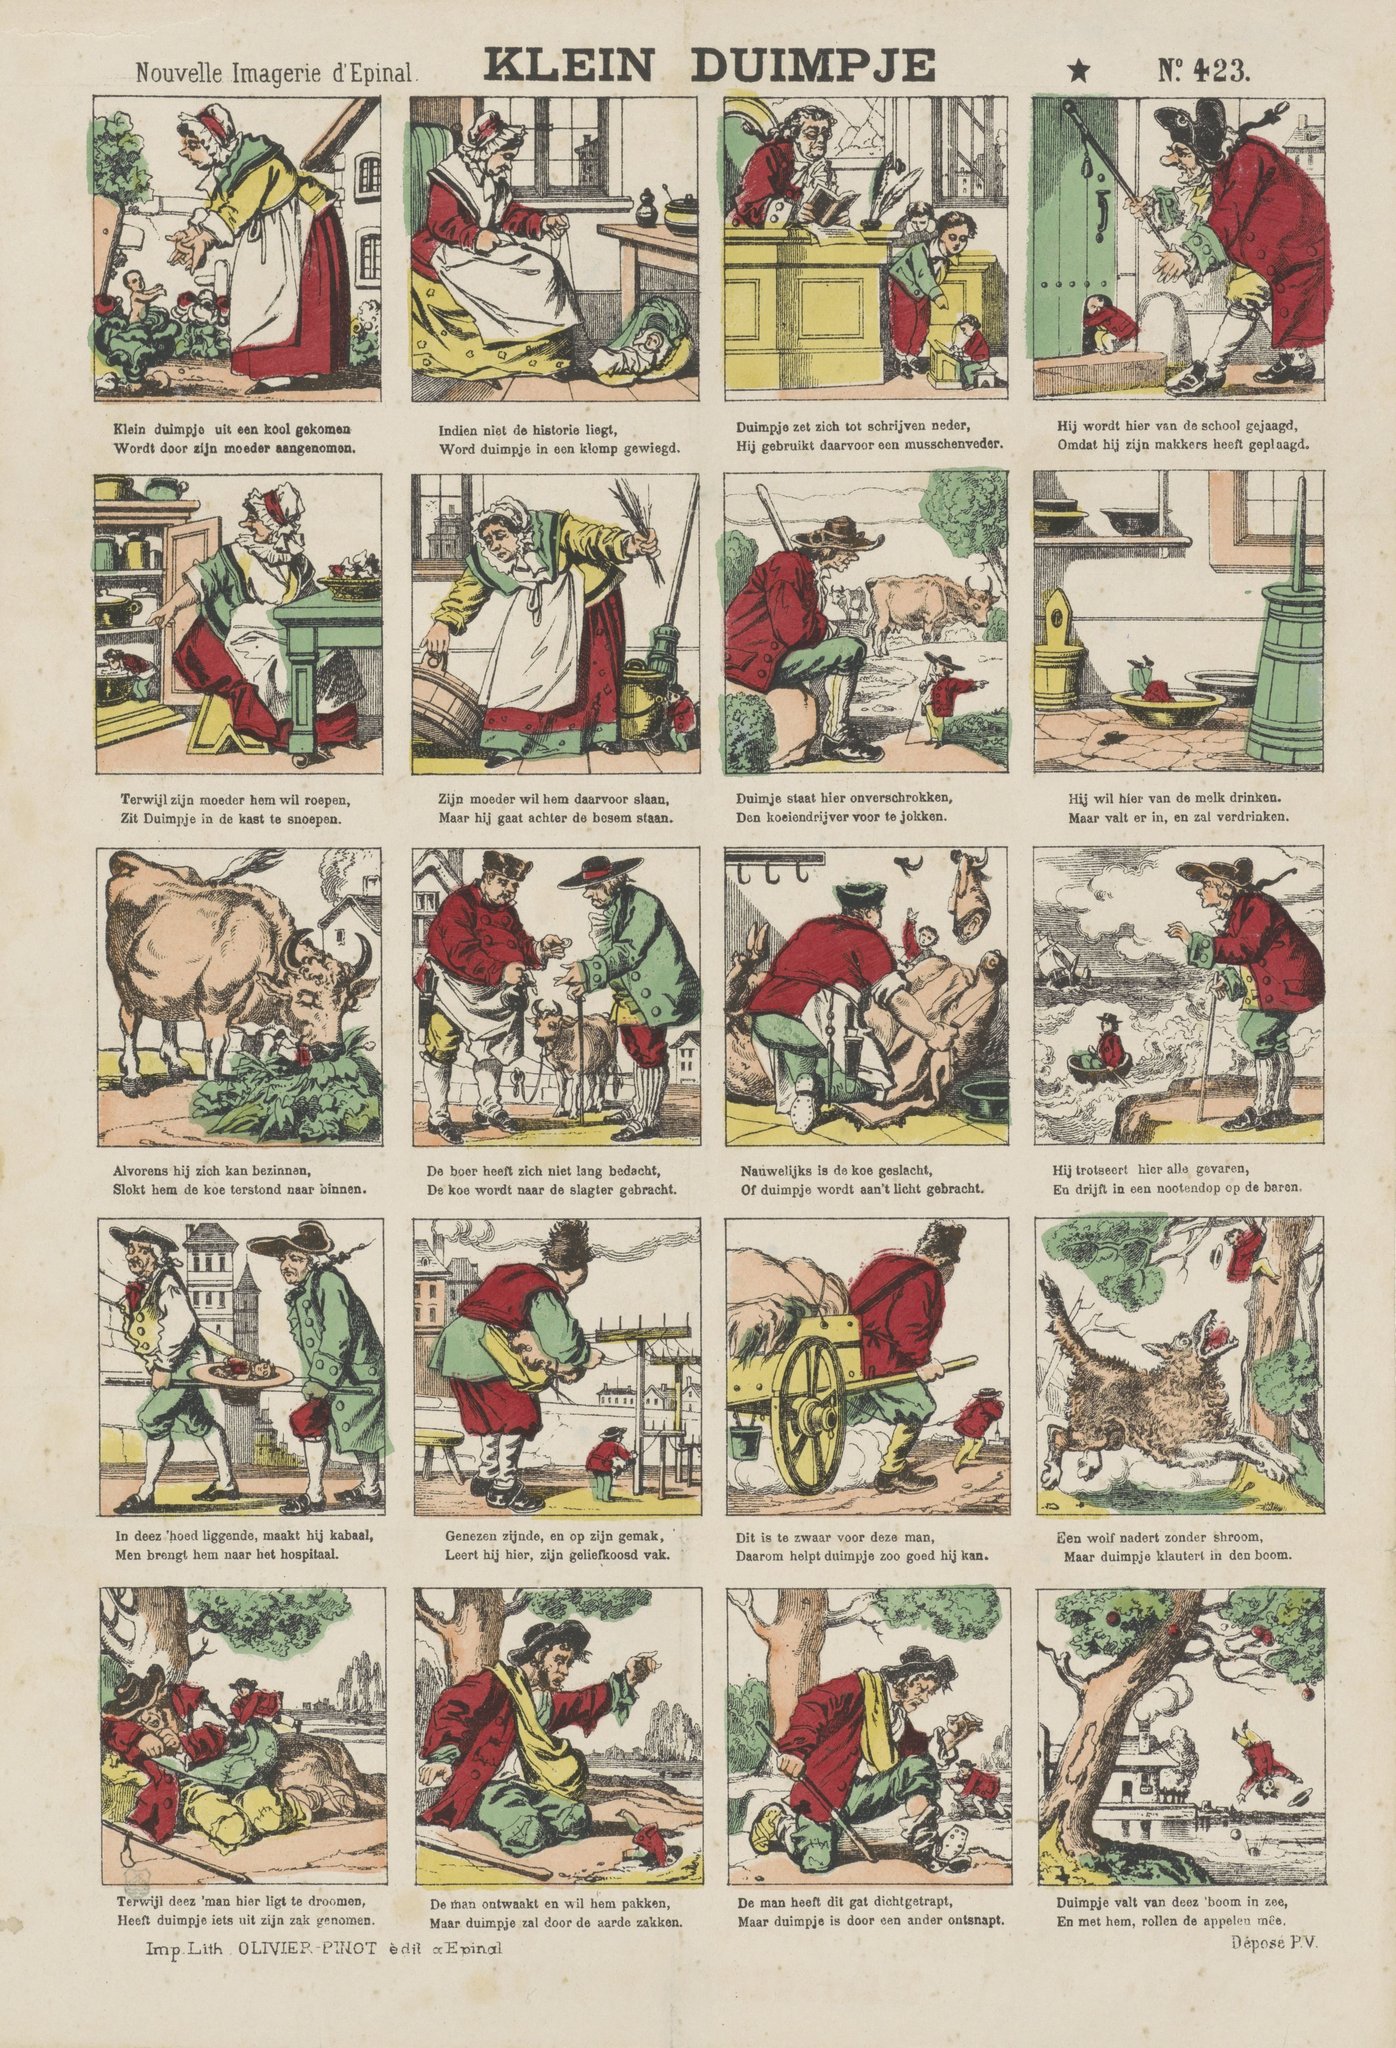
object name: popular print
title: Nouvelle imagerie d'Epinal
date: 1874-1888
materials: paper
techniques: colour, letterpress printing, lithograph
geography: europe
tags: tales and fairy tales: little thumbling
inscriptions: collector's mark: Lugt 2760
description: Blad met 16 voorstellingen uit het verhaal van Klein Duimpje. Onder elke voorstelling een onderschrift in het Nederlands. Genummerd rechtsboven: No. 423.